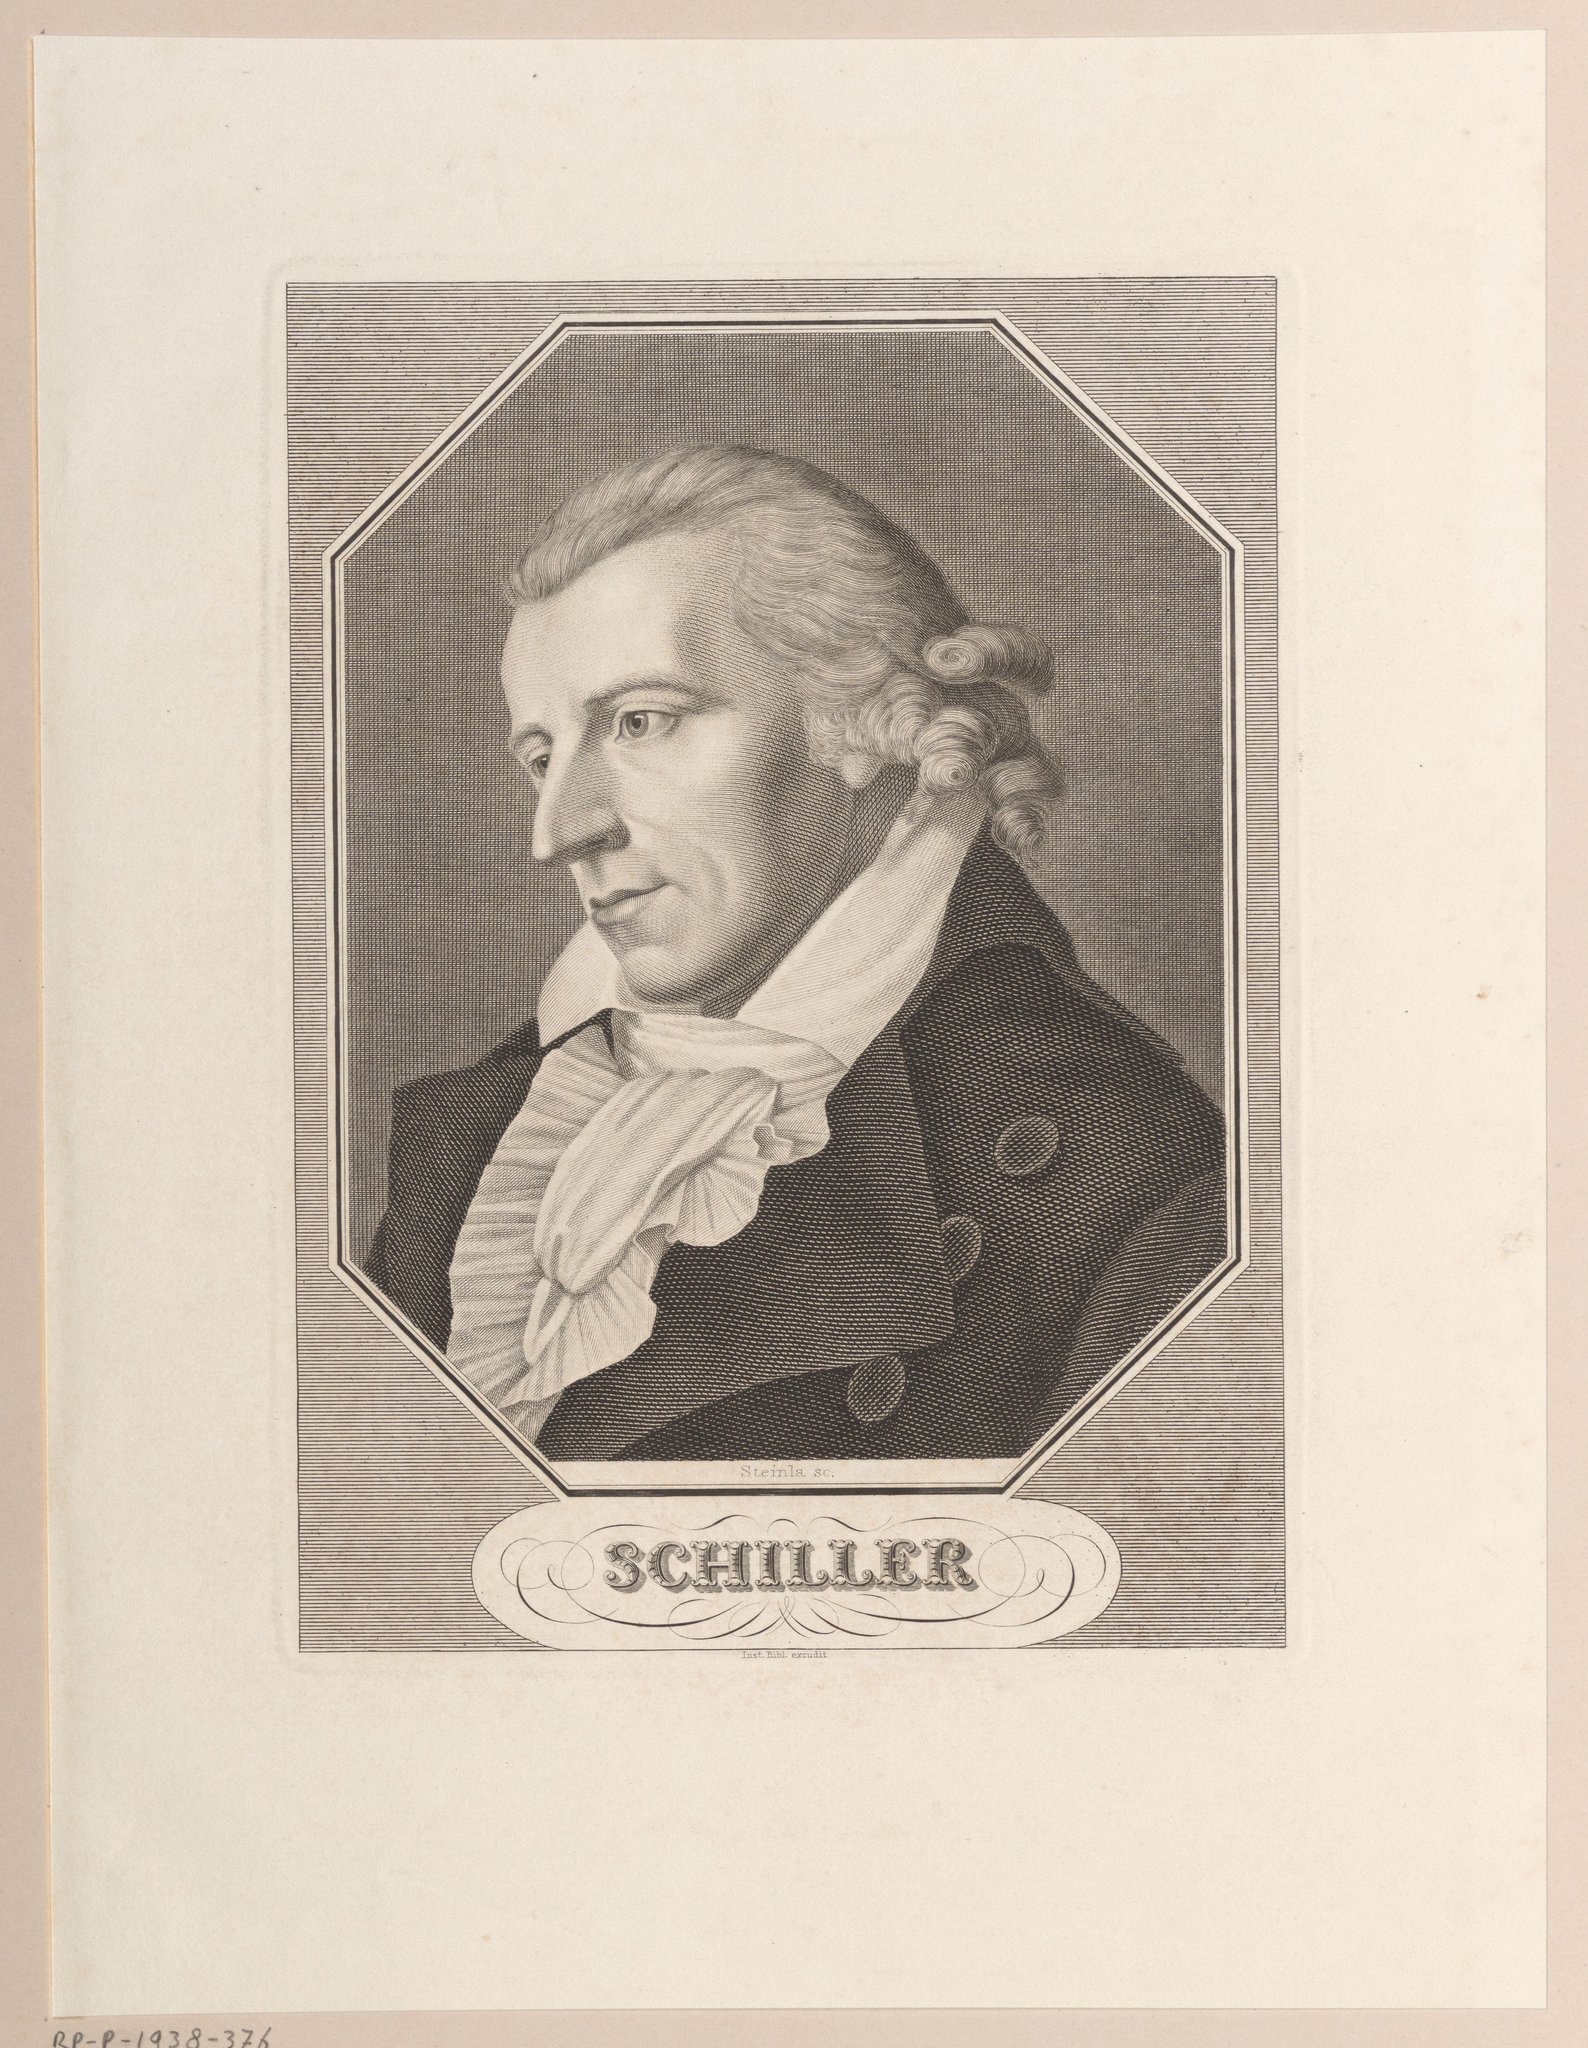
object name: print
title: Portret van Friedrich von Schiller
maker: moritz steinla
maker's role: painter, print maker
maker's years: 1791-1858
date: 1801-1858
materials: paper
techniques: engraving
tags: friedrich von schiller, scholar, philosopher, historical persons, portrait of a writer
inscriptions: collector's mark: Lugt 2228